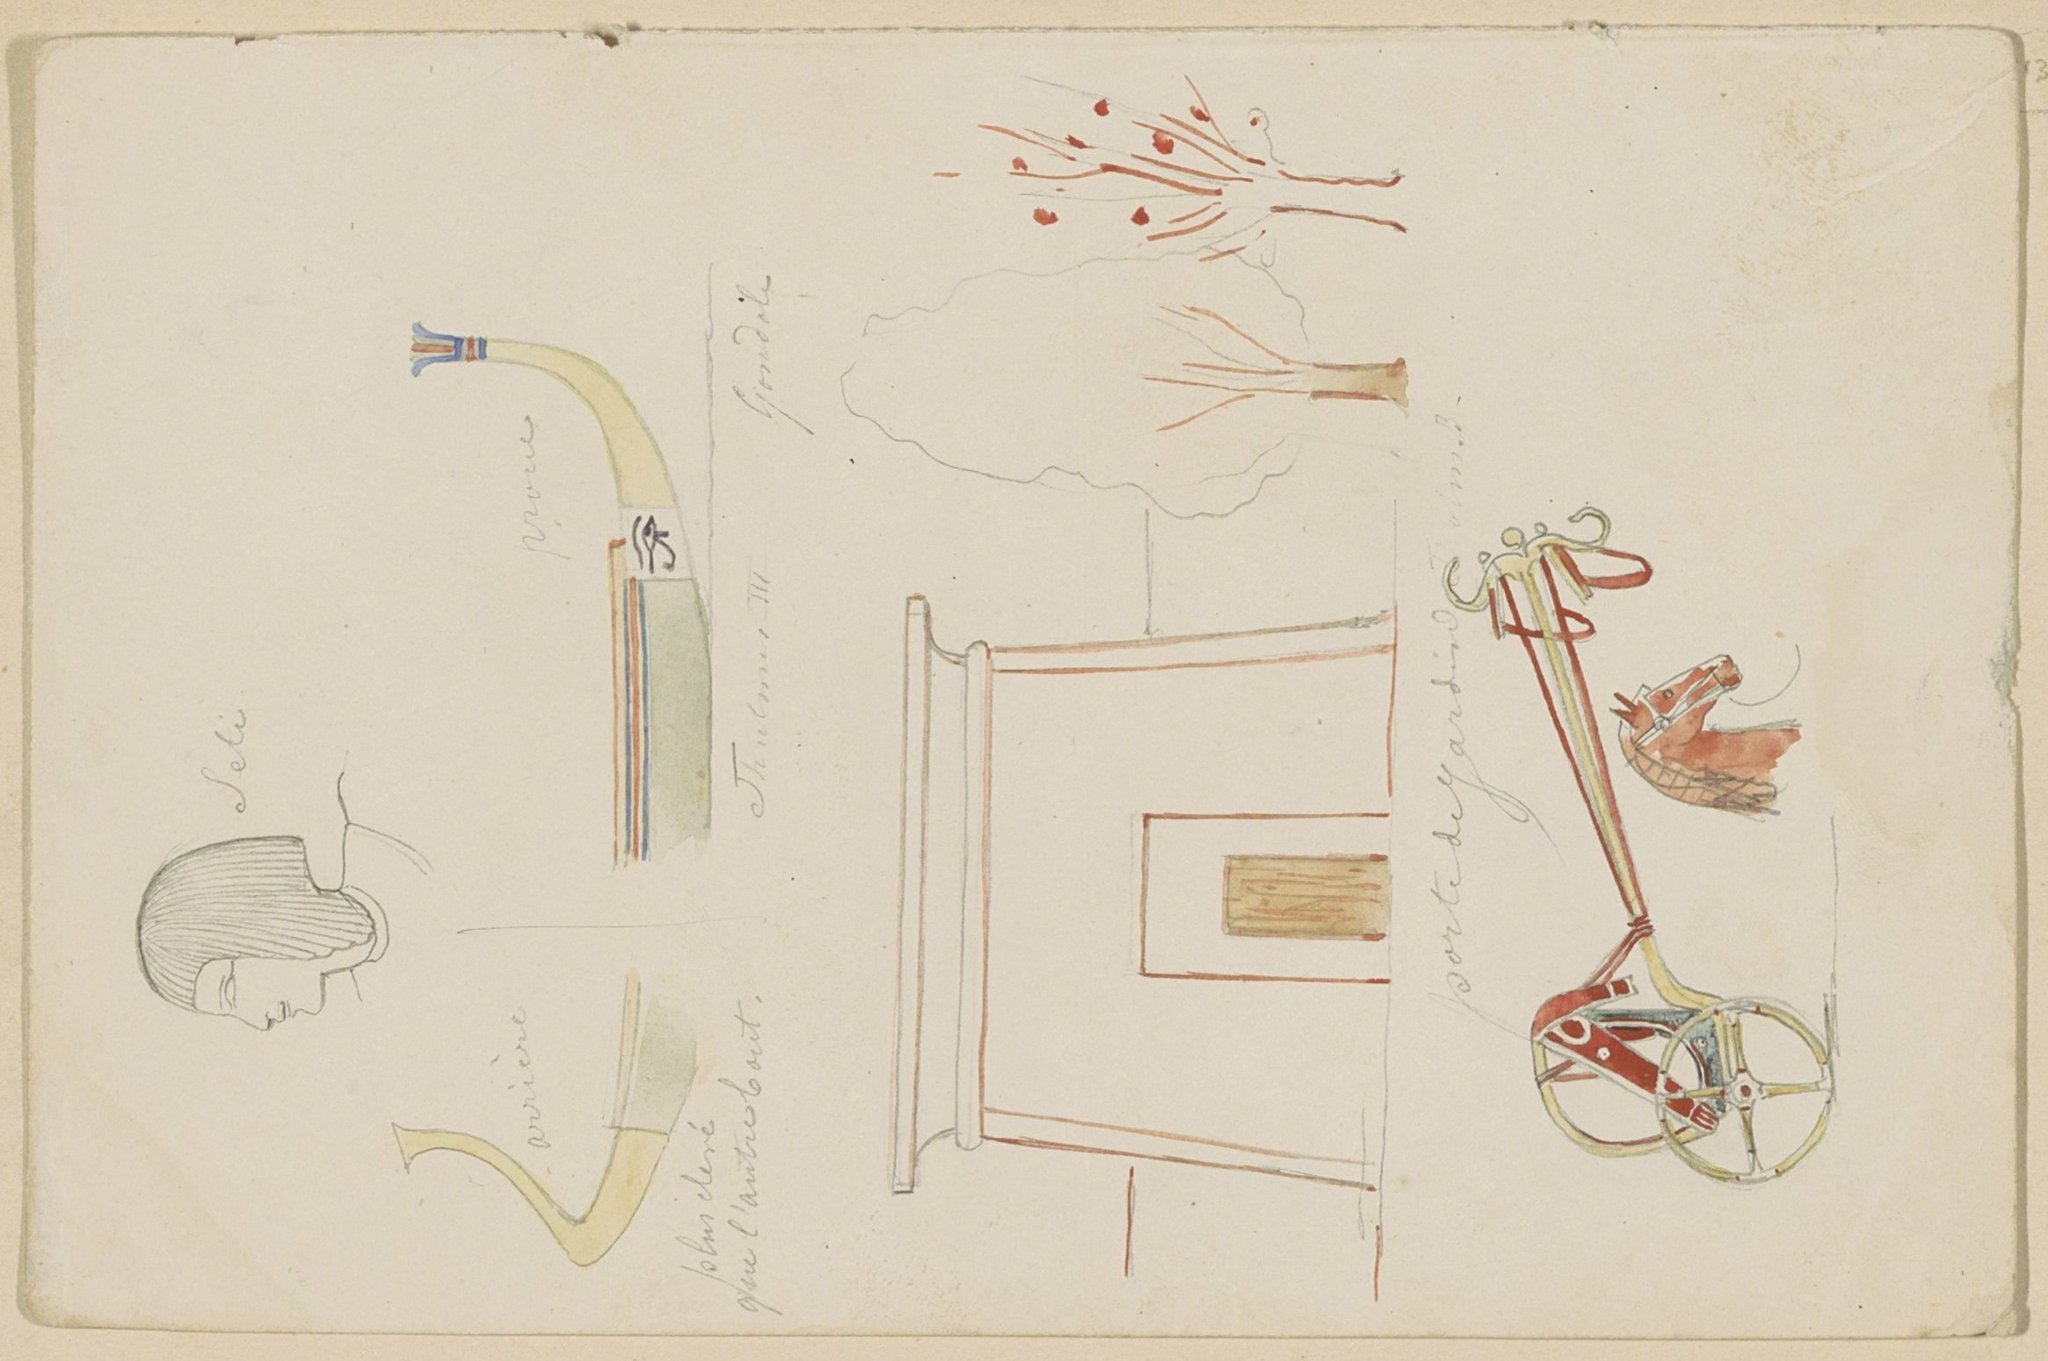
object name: sketchbook leaf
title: Studieblad, onder andere met een gondel en een kop van farao Seti I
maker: willem de famars testas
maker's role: draughtsman, painter, print maker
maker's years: 1834-1896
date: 1858-1860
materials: paper, pencil, watercolor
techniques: brush, pen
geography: egypt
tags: horse, gondola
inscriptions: annotation: ‘Seti/ arrière/ proue/ plus deré/ que l'antre bout/ Thotmes III Gondola/ porte de Jardin Thotmes’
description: Tevens een architectuurstudie, paardenkop en een wagen. Verso-zijde van een los blad behorende bij een schetsboek met 23 bladen met schetsen gemaakt tijdens een reis door Egypte.